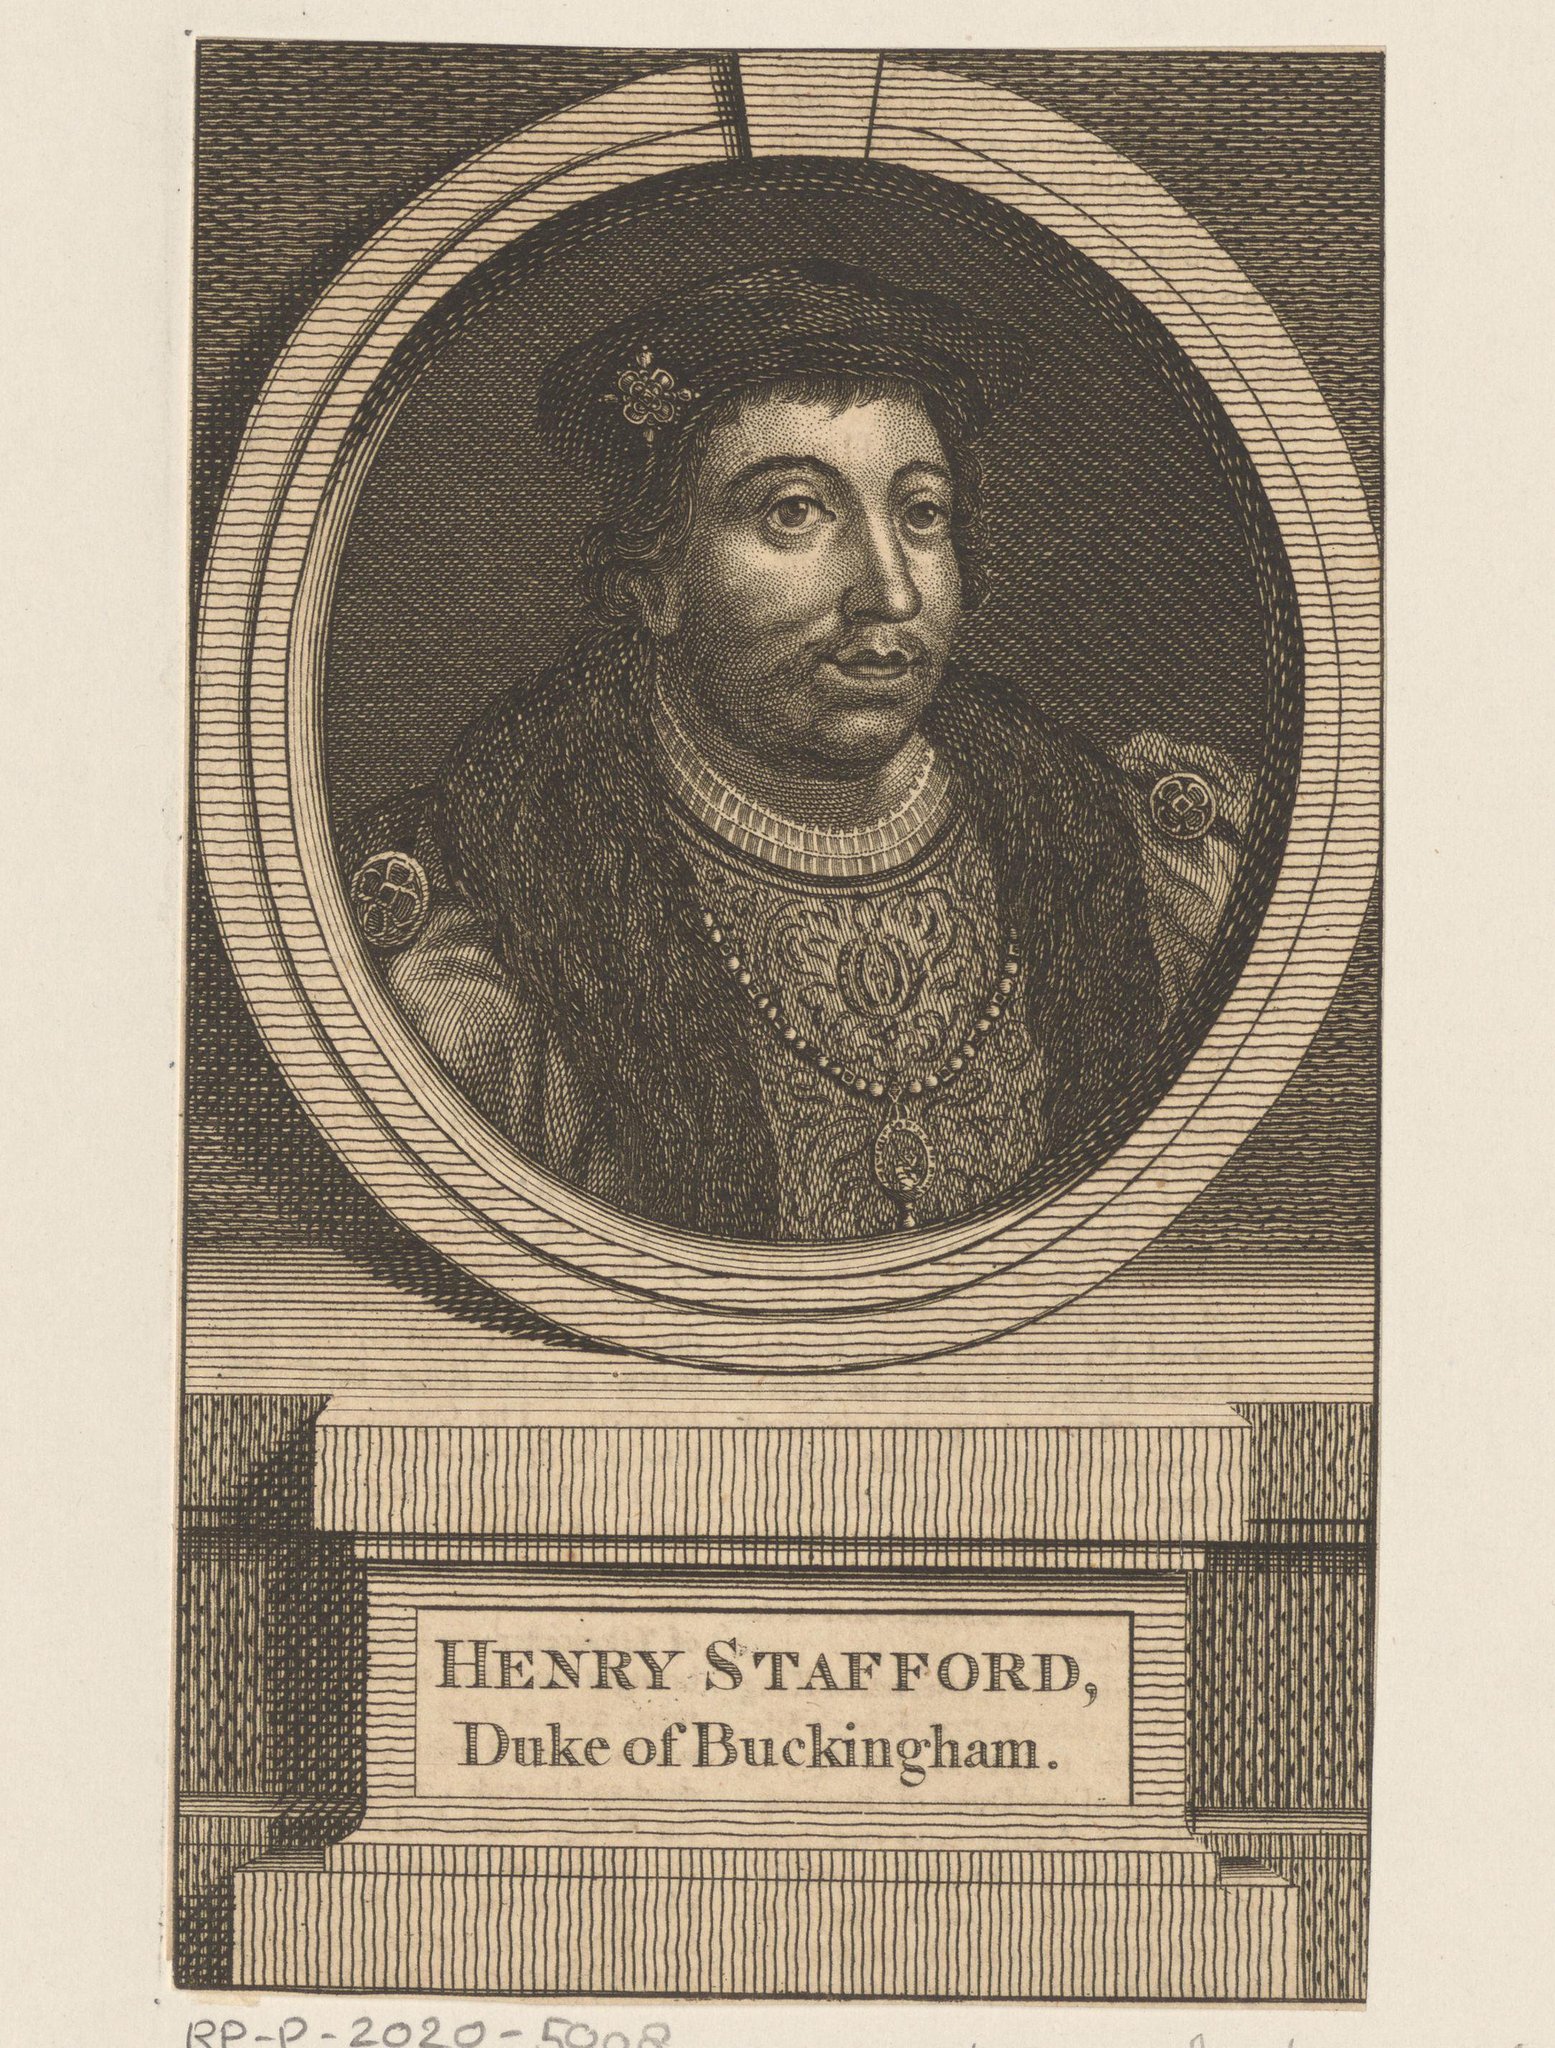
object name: print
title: Portret van Henry Stafford, hertog van Buckingham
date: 1747-1781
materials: paper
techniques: engraving, etching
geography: london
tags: historical persons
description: Prent uit: The Universal Magazine of Knowledge and Pleasure, 1747-1781.